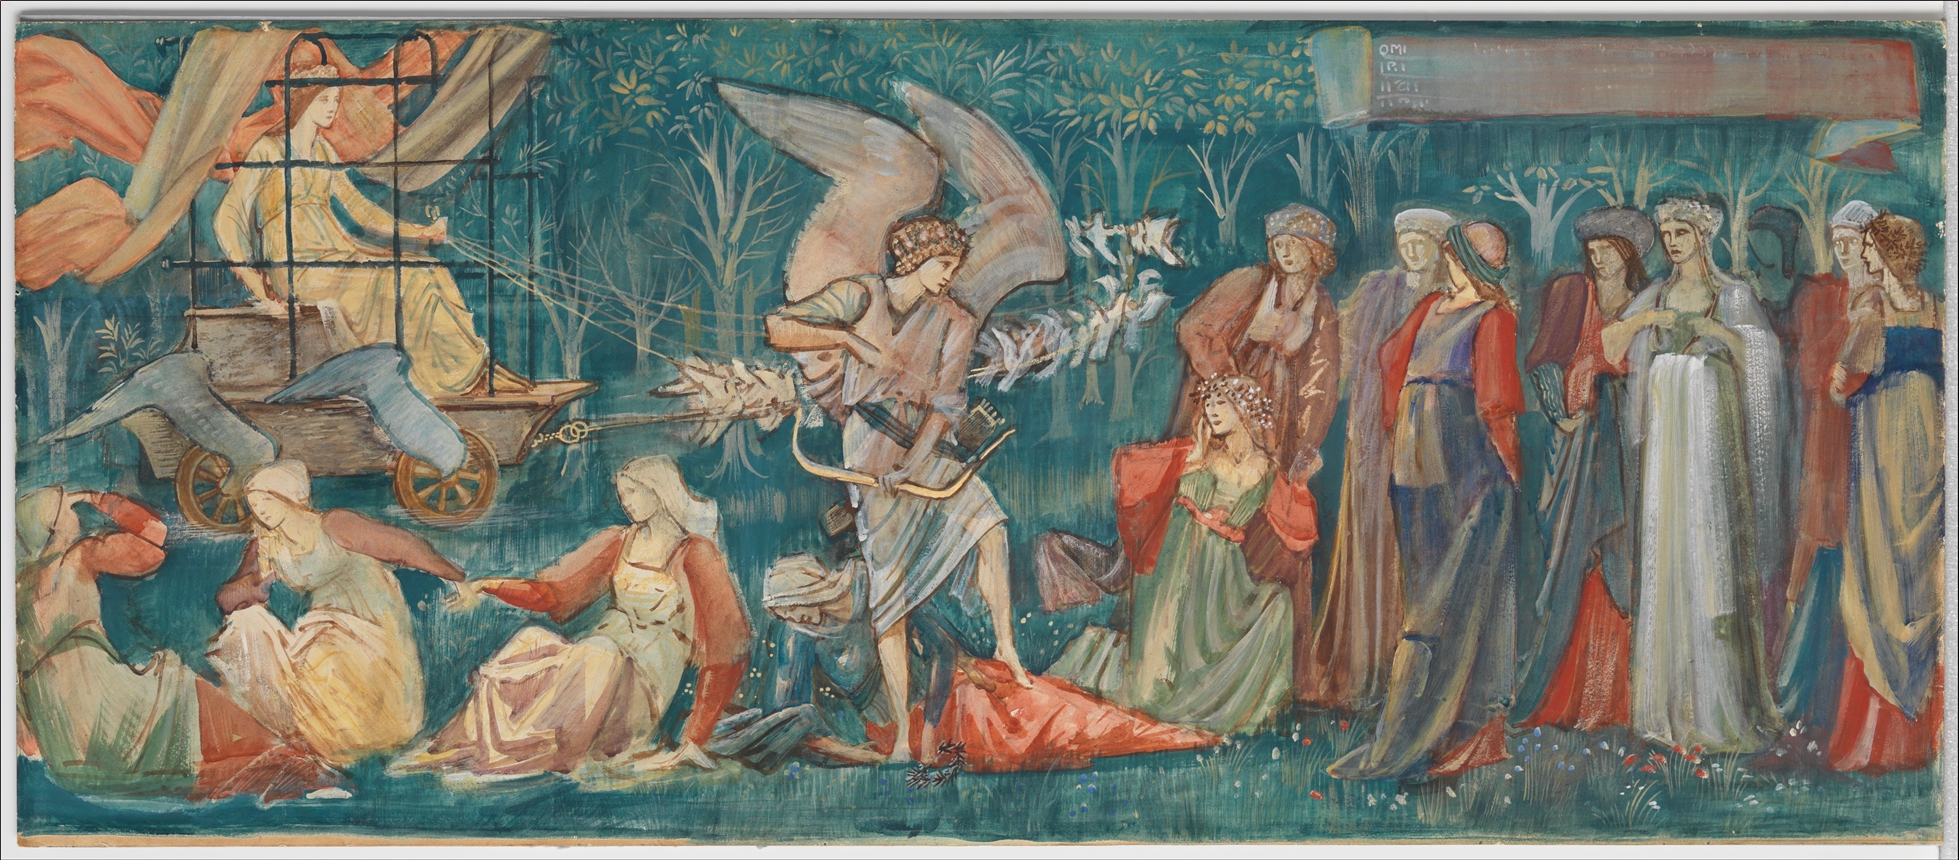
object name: drawing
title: The Passing of Venus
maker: sir edward burne-jones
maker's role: artist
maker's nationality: british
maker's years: 1833-1898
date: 1898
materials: cardboard, gouache, paint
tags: bow and arrow,cupid,venus,trees,carriages